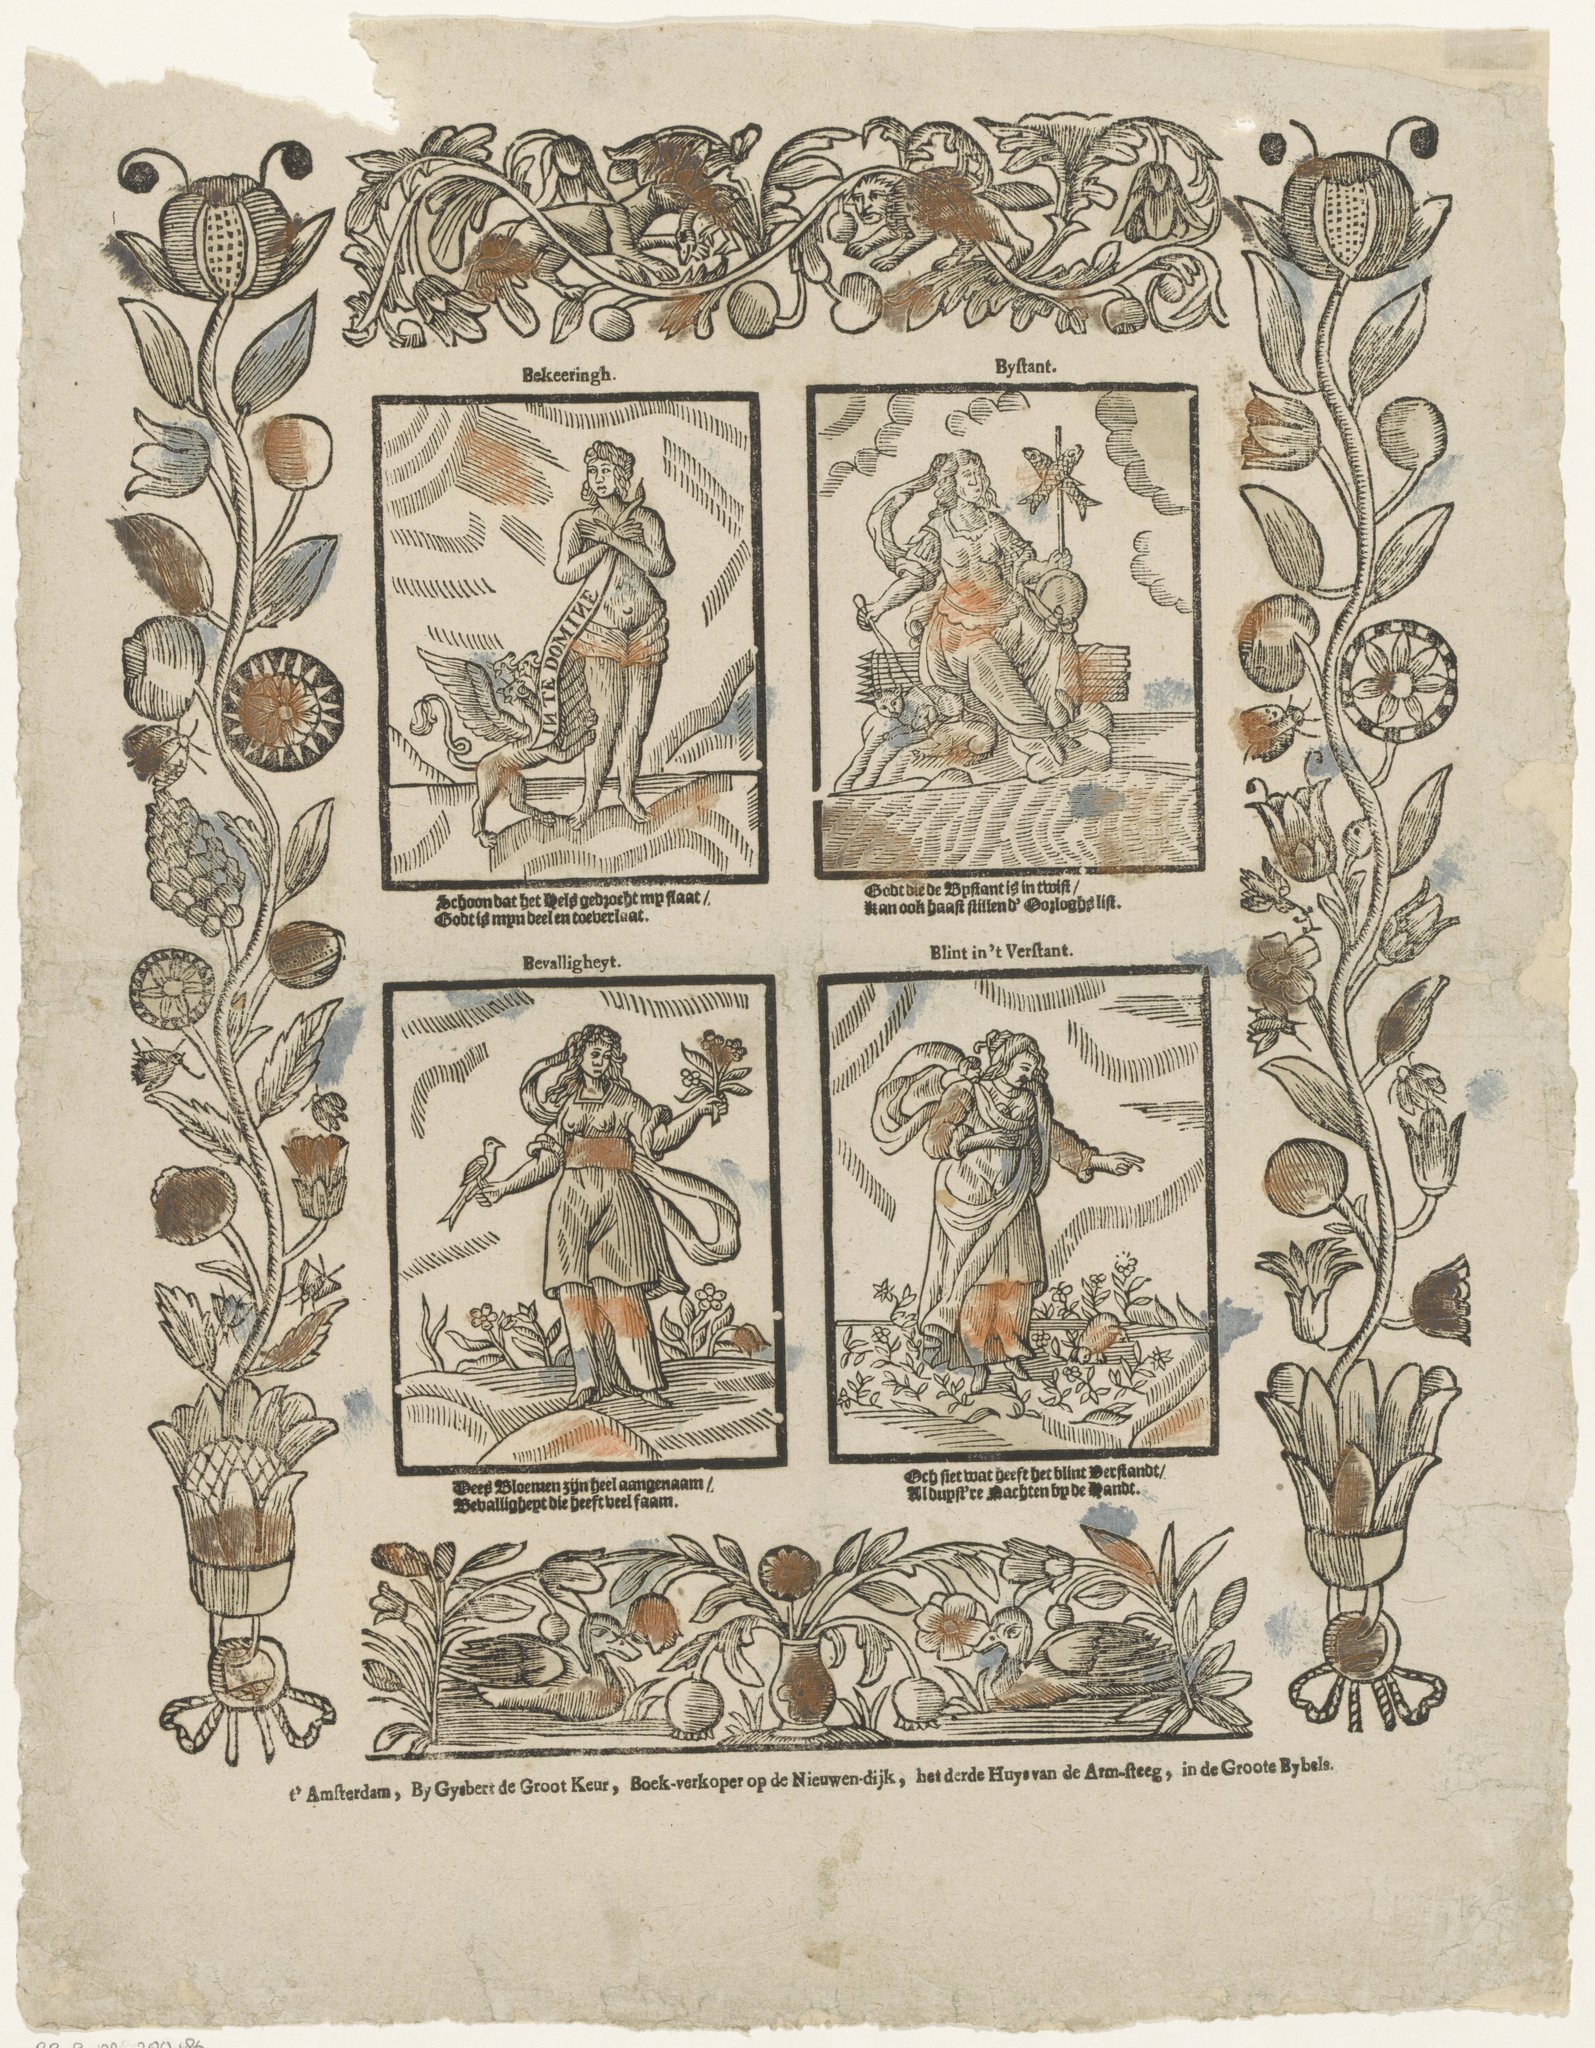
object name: print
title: Bekeeringh, Bystant, Bevalligheyt, Blint in 't Verstant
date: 1738-1767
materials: paper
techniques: colour, letterpress printing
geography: netherlands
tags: grace, charm; 'gratia', 'venustà' (ripa), intellectual blindness; 'cecità della mente' (ripa), 'ajuto', 'soccorso' (ripa), 'conversatione' (ripa)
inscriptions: collector's mark: Lugt 2760, collector's mark: Lugt 2228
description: Blad met vier voorstellingen: Bekeeringh, Bystant, Bevalligheyt, Blint in 't Verstant. Onder elke afbeelding een tweeregelig vers. Omgeven door een lijst van bloemenranken, insecten, leeuwen en eenden.